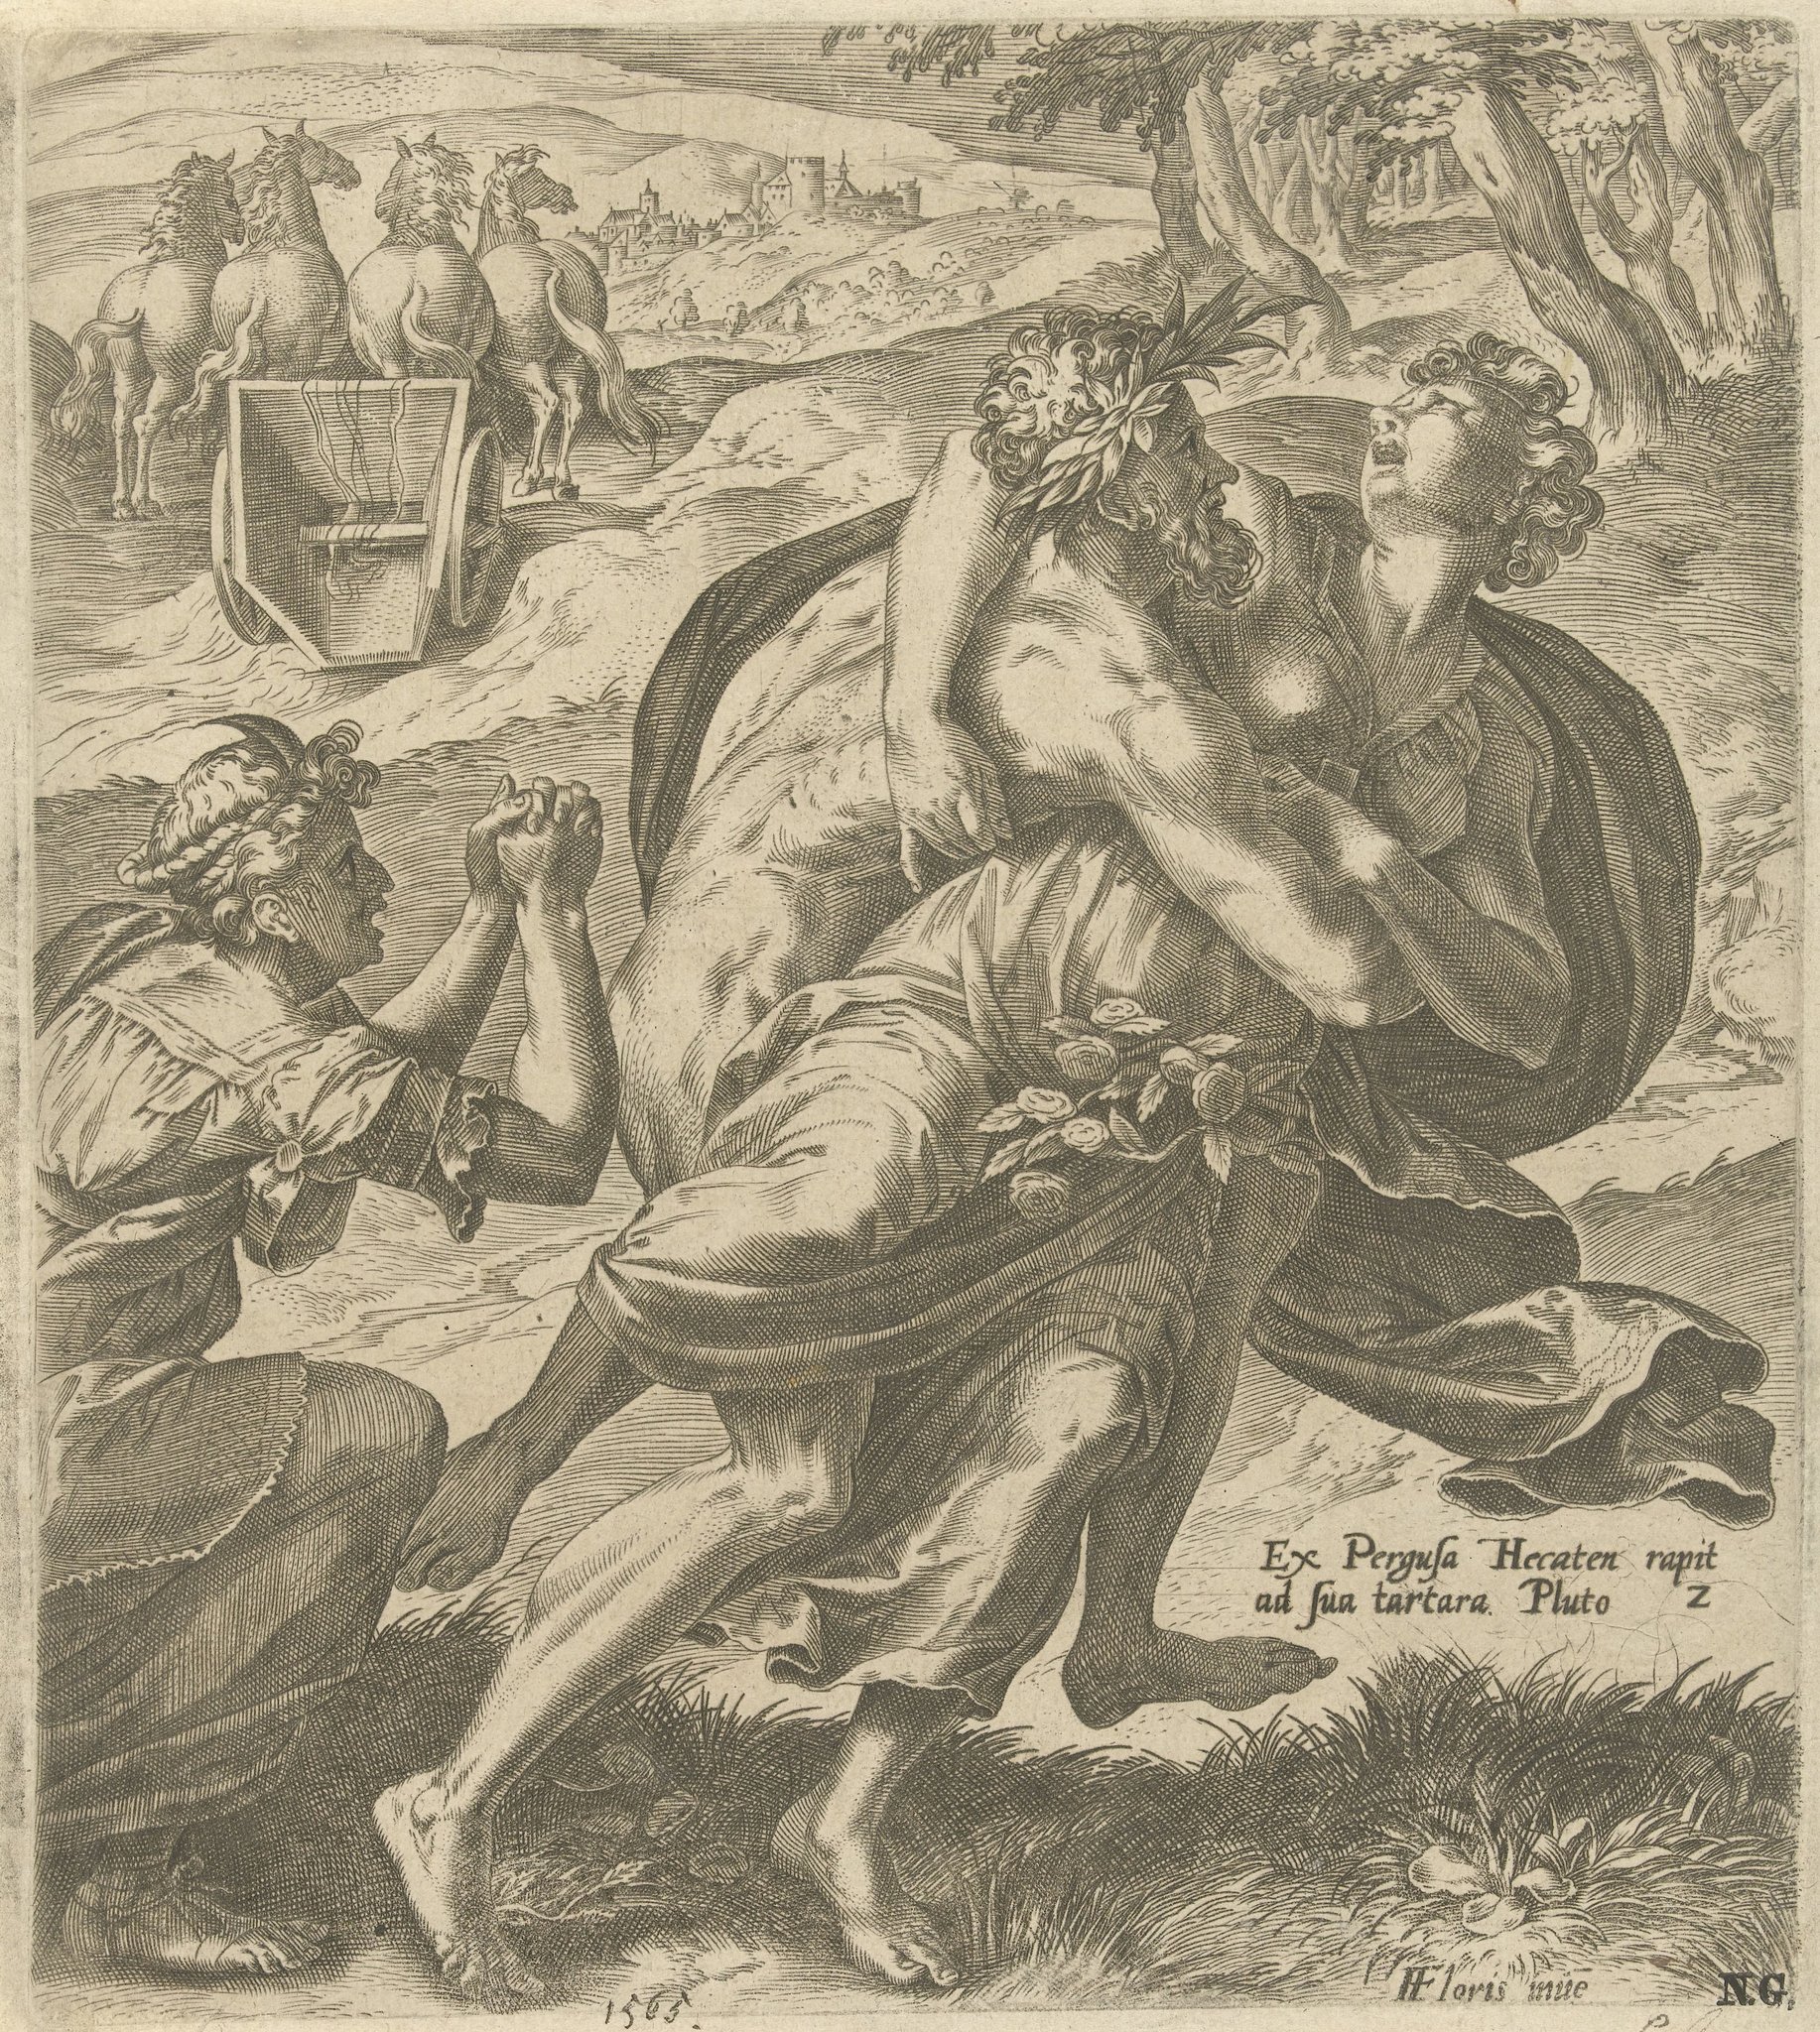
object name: print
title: De geschiedenis van Pluto en Proserpina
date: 1565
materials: paper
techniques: engraving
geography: antwerp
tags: the rape of proserpina (by pluto in his chariot); possibly with diana and minerva trying to rescue her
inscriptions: collector's mark: Lugt 2228, collector's mark: Lugt 1968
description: Pluto sleept Proserpina naar zijn zegewagen. Proserpina schreeuwt om hulp. De paarden met de zegewagen staan bij een bos te wachten.